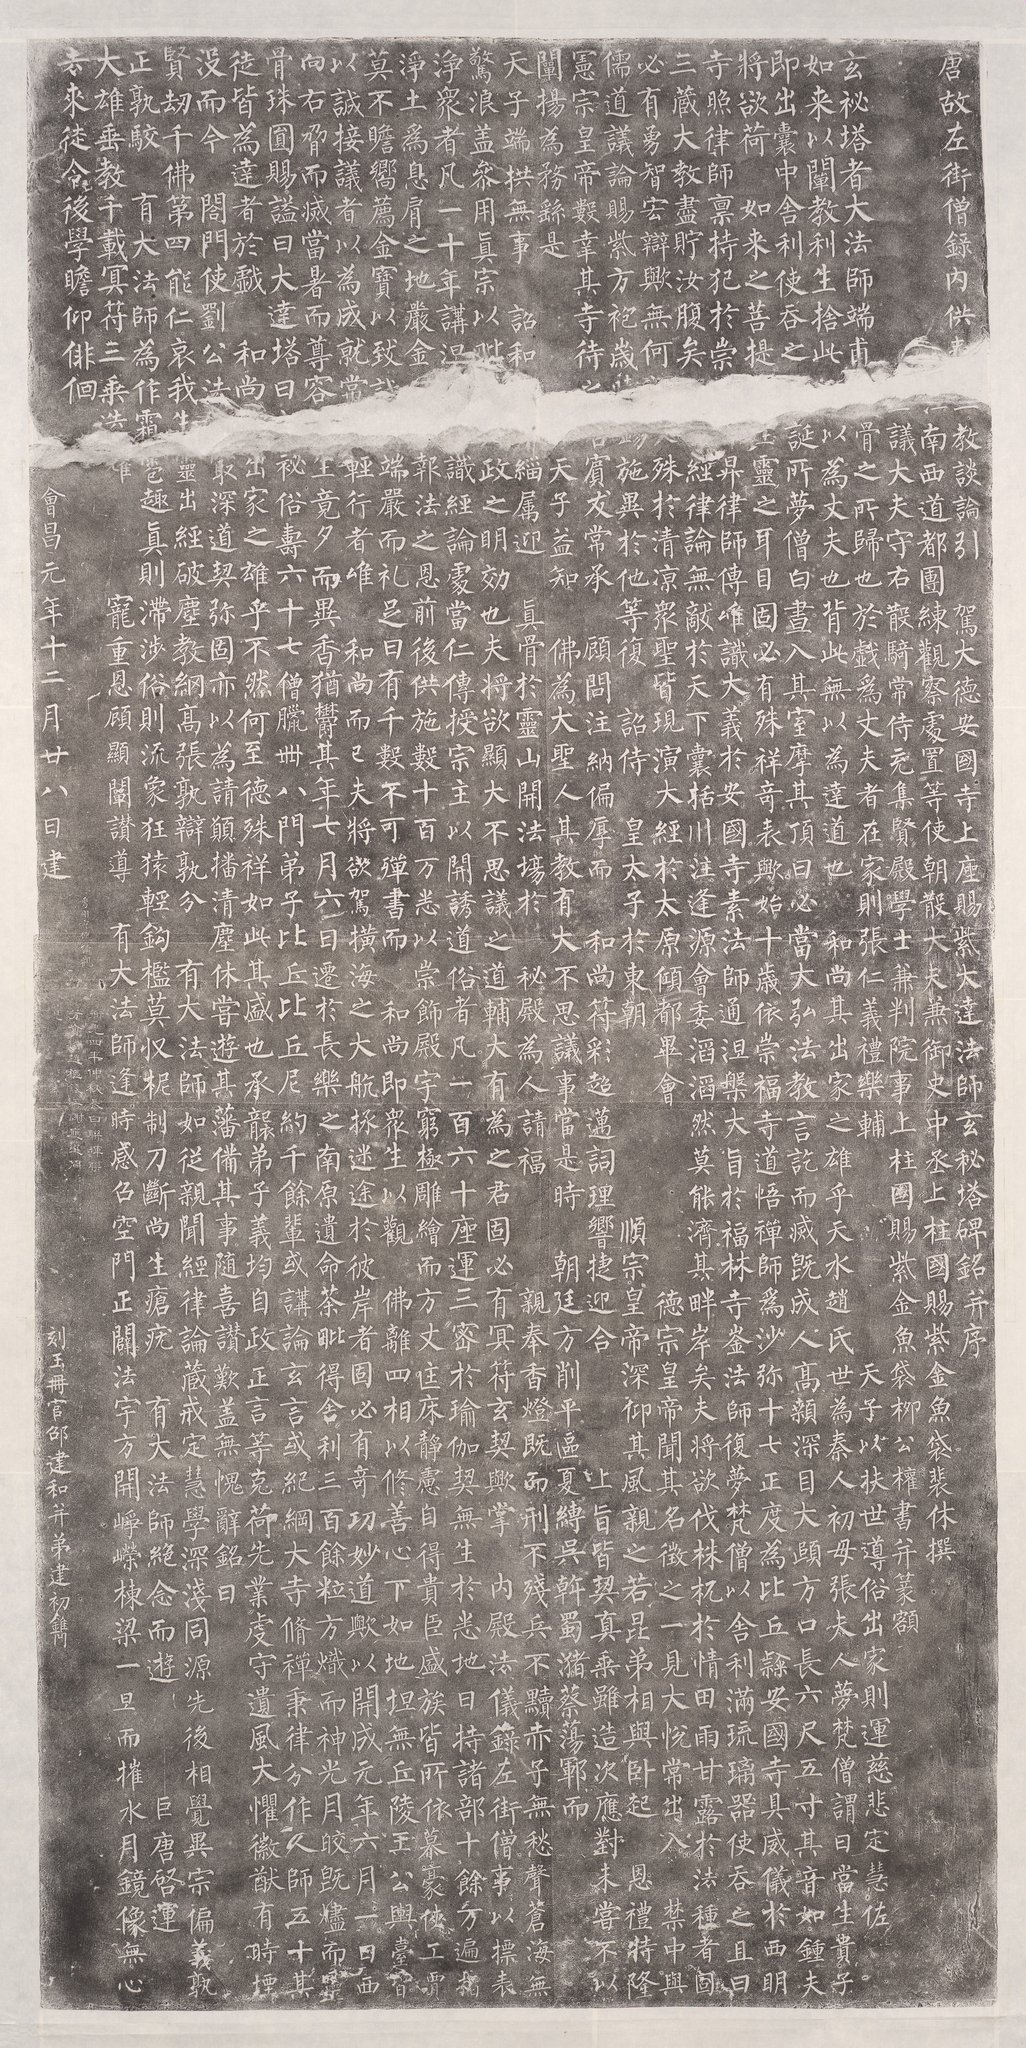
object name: rubbing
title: Stele of the Xuanmi Pagoda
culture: chinese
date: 1901-2000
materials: ink, paper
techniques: carving